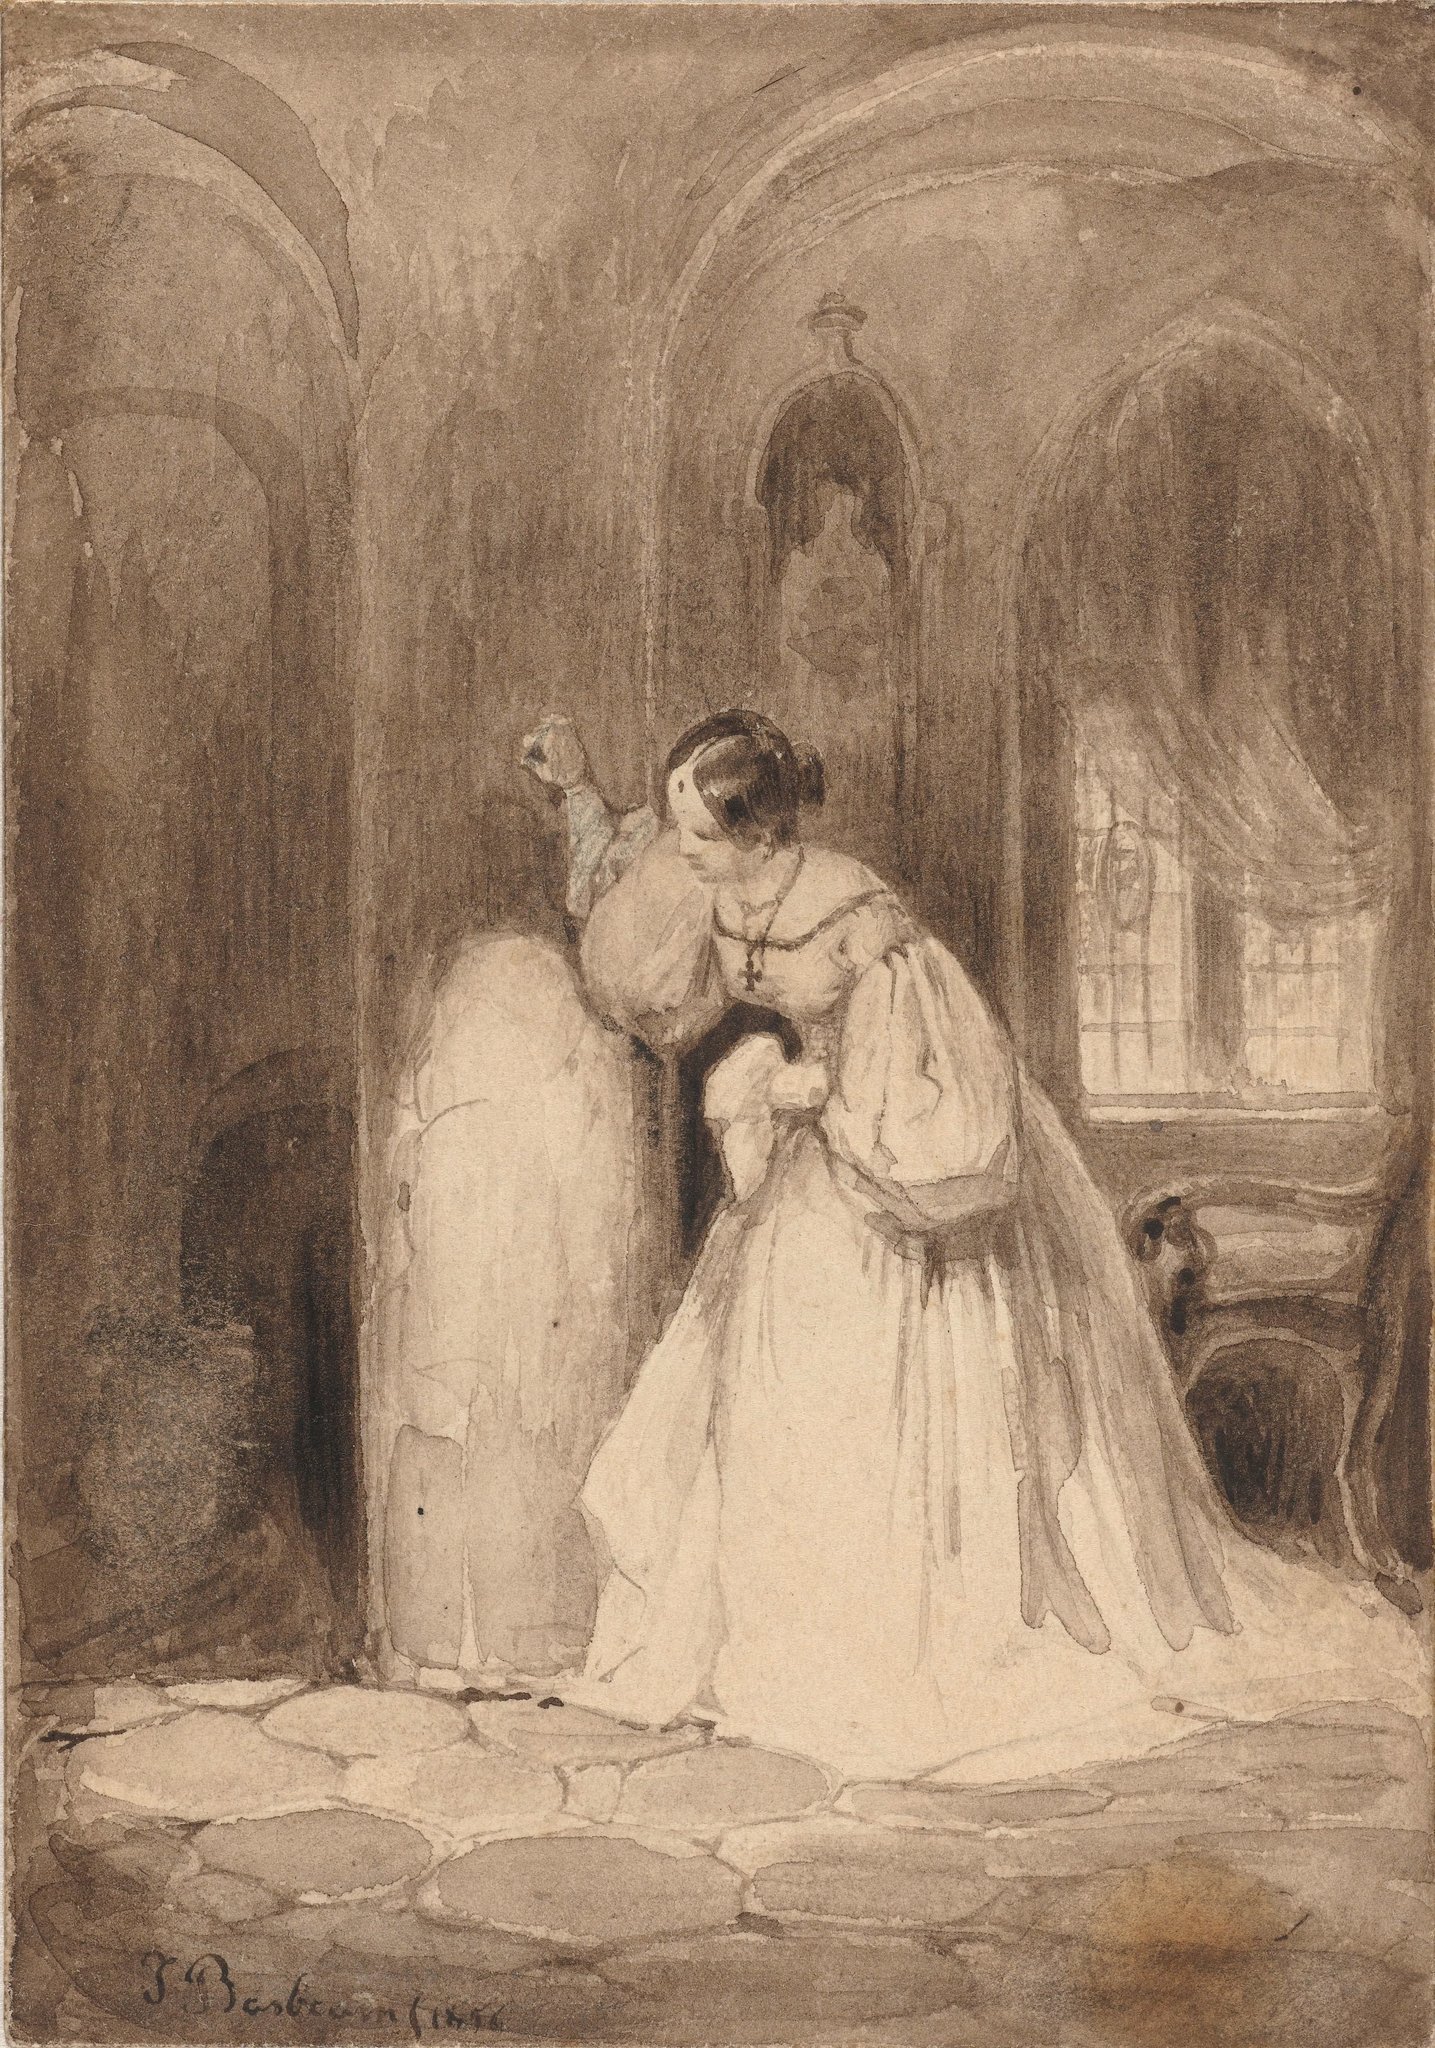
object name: drawing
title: Interieur met staande vrouw bij een zuil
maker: johannes bosboom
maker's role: draughtsman, painter, print maker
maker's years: 1817-1891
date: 1856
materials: paper, pencil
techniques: brush